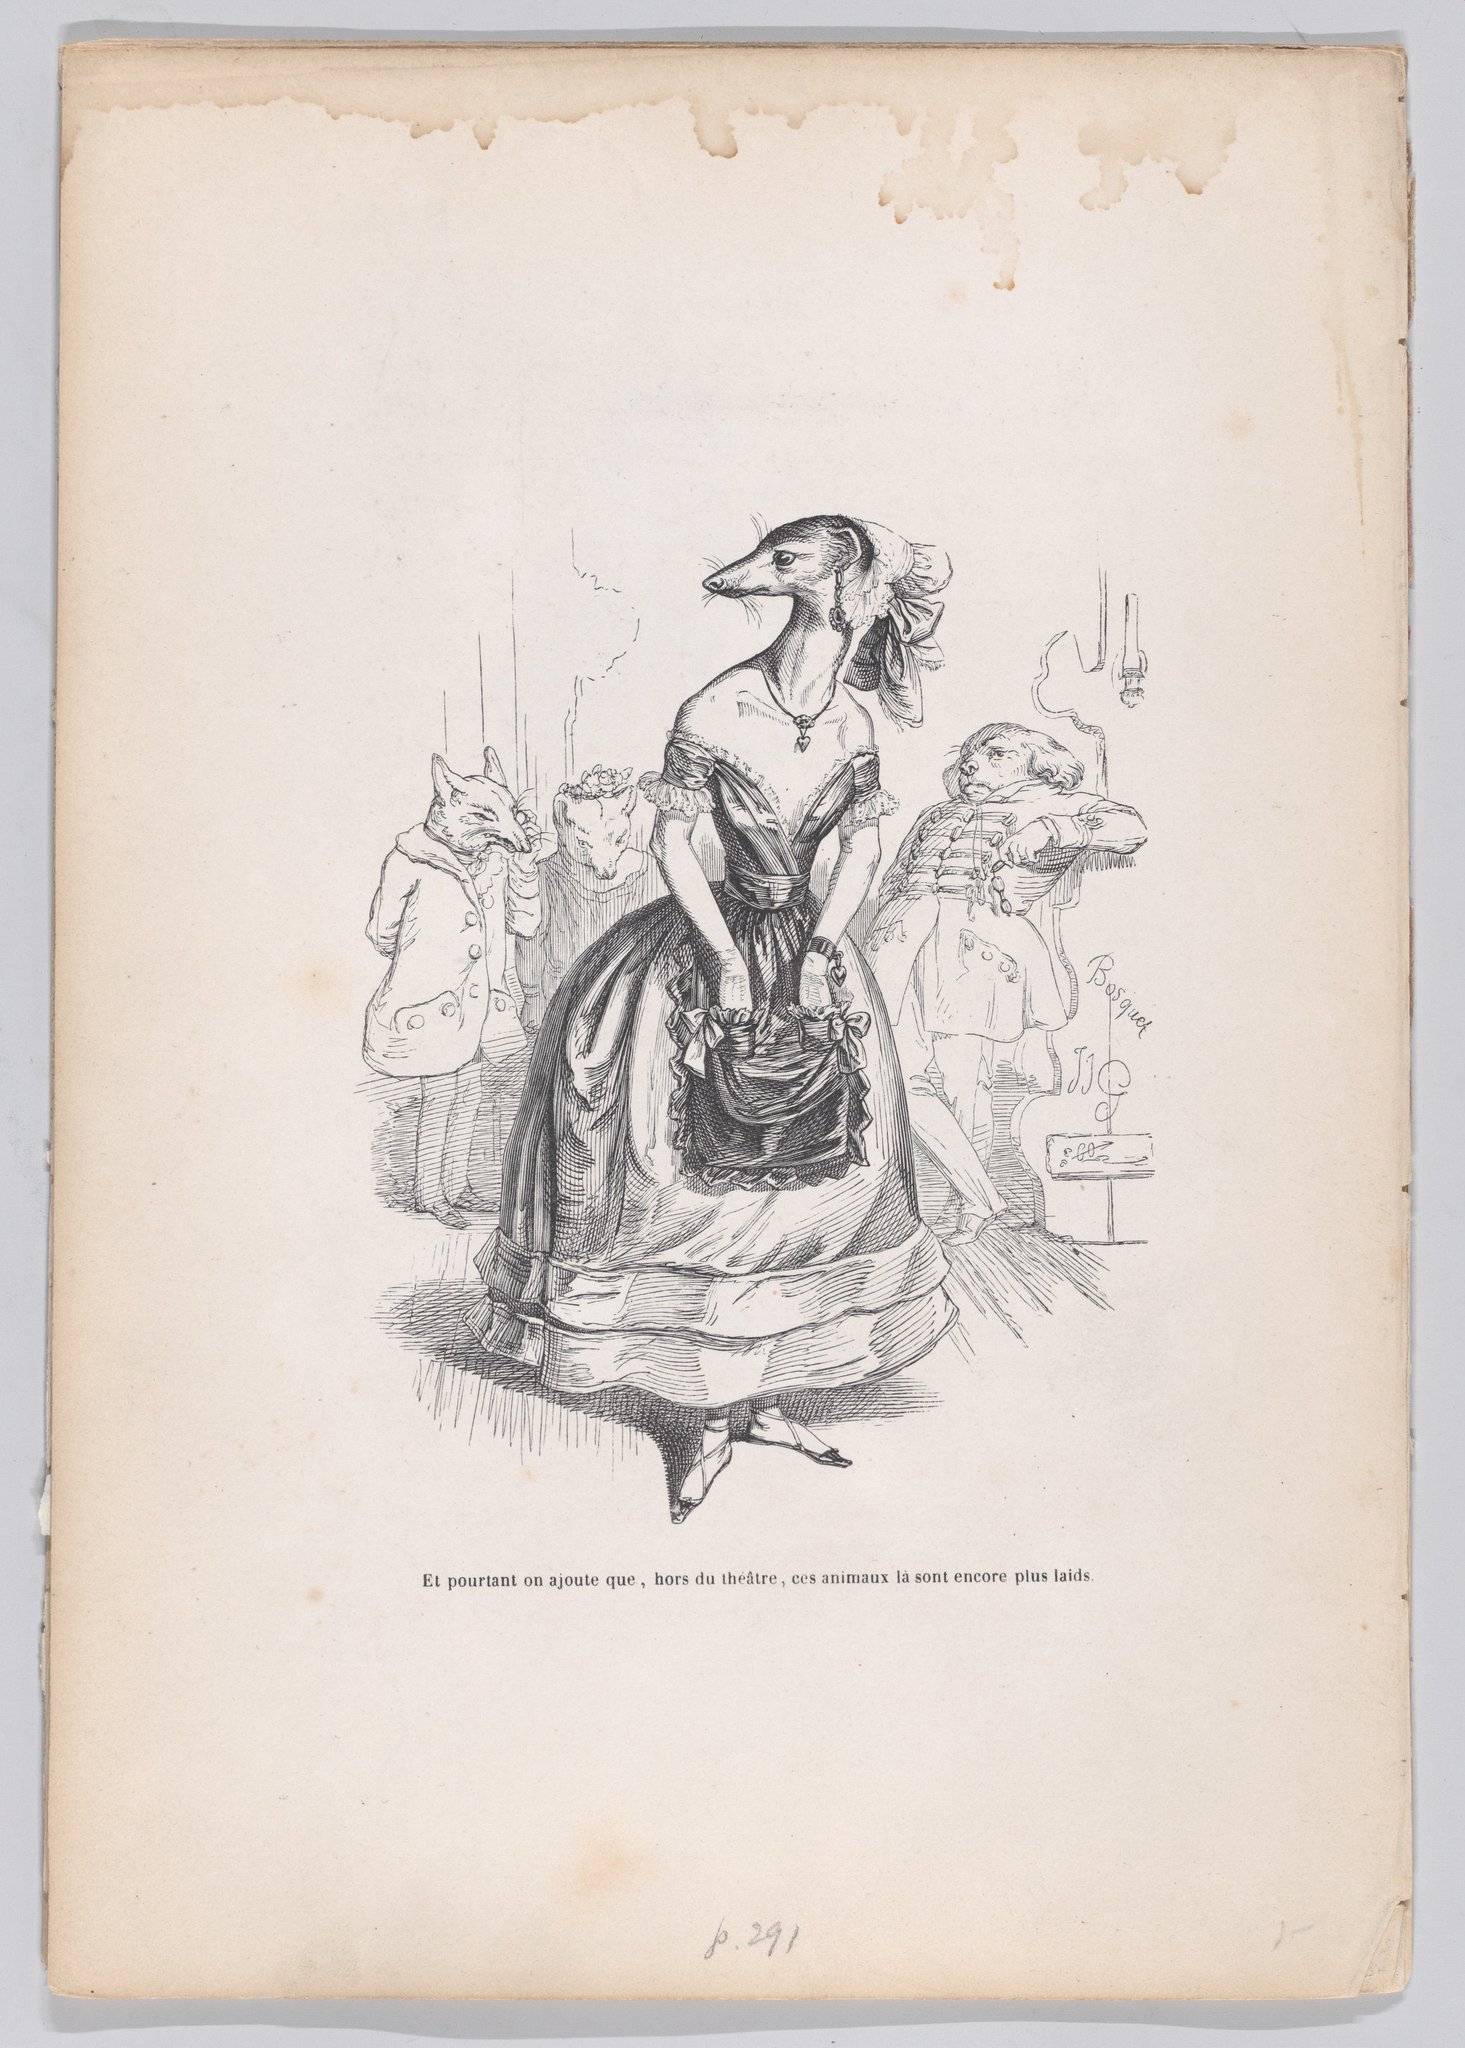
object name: print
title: And yet we add that, outside the theater, these animals are even more ugly, from "Scenes from the Private and Public Life of Animals"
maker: j. j. grandville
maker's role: illustrator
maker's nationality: french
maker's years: 1803-1847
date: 1837-1847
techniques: engraving